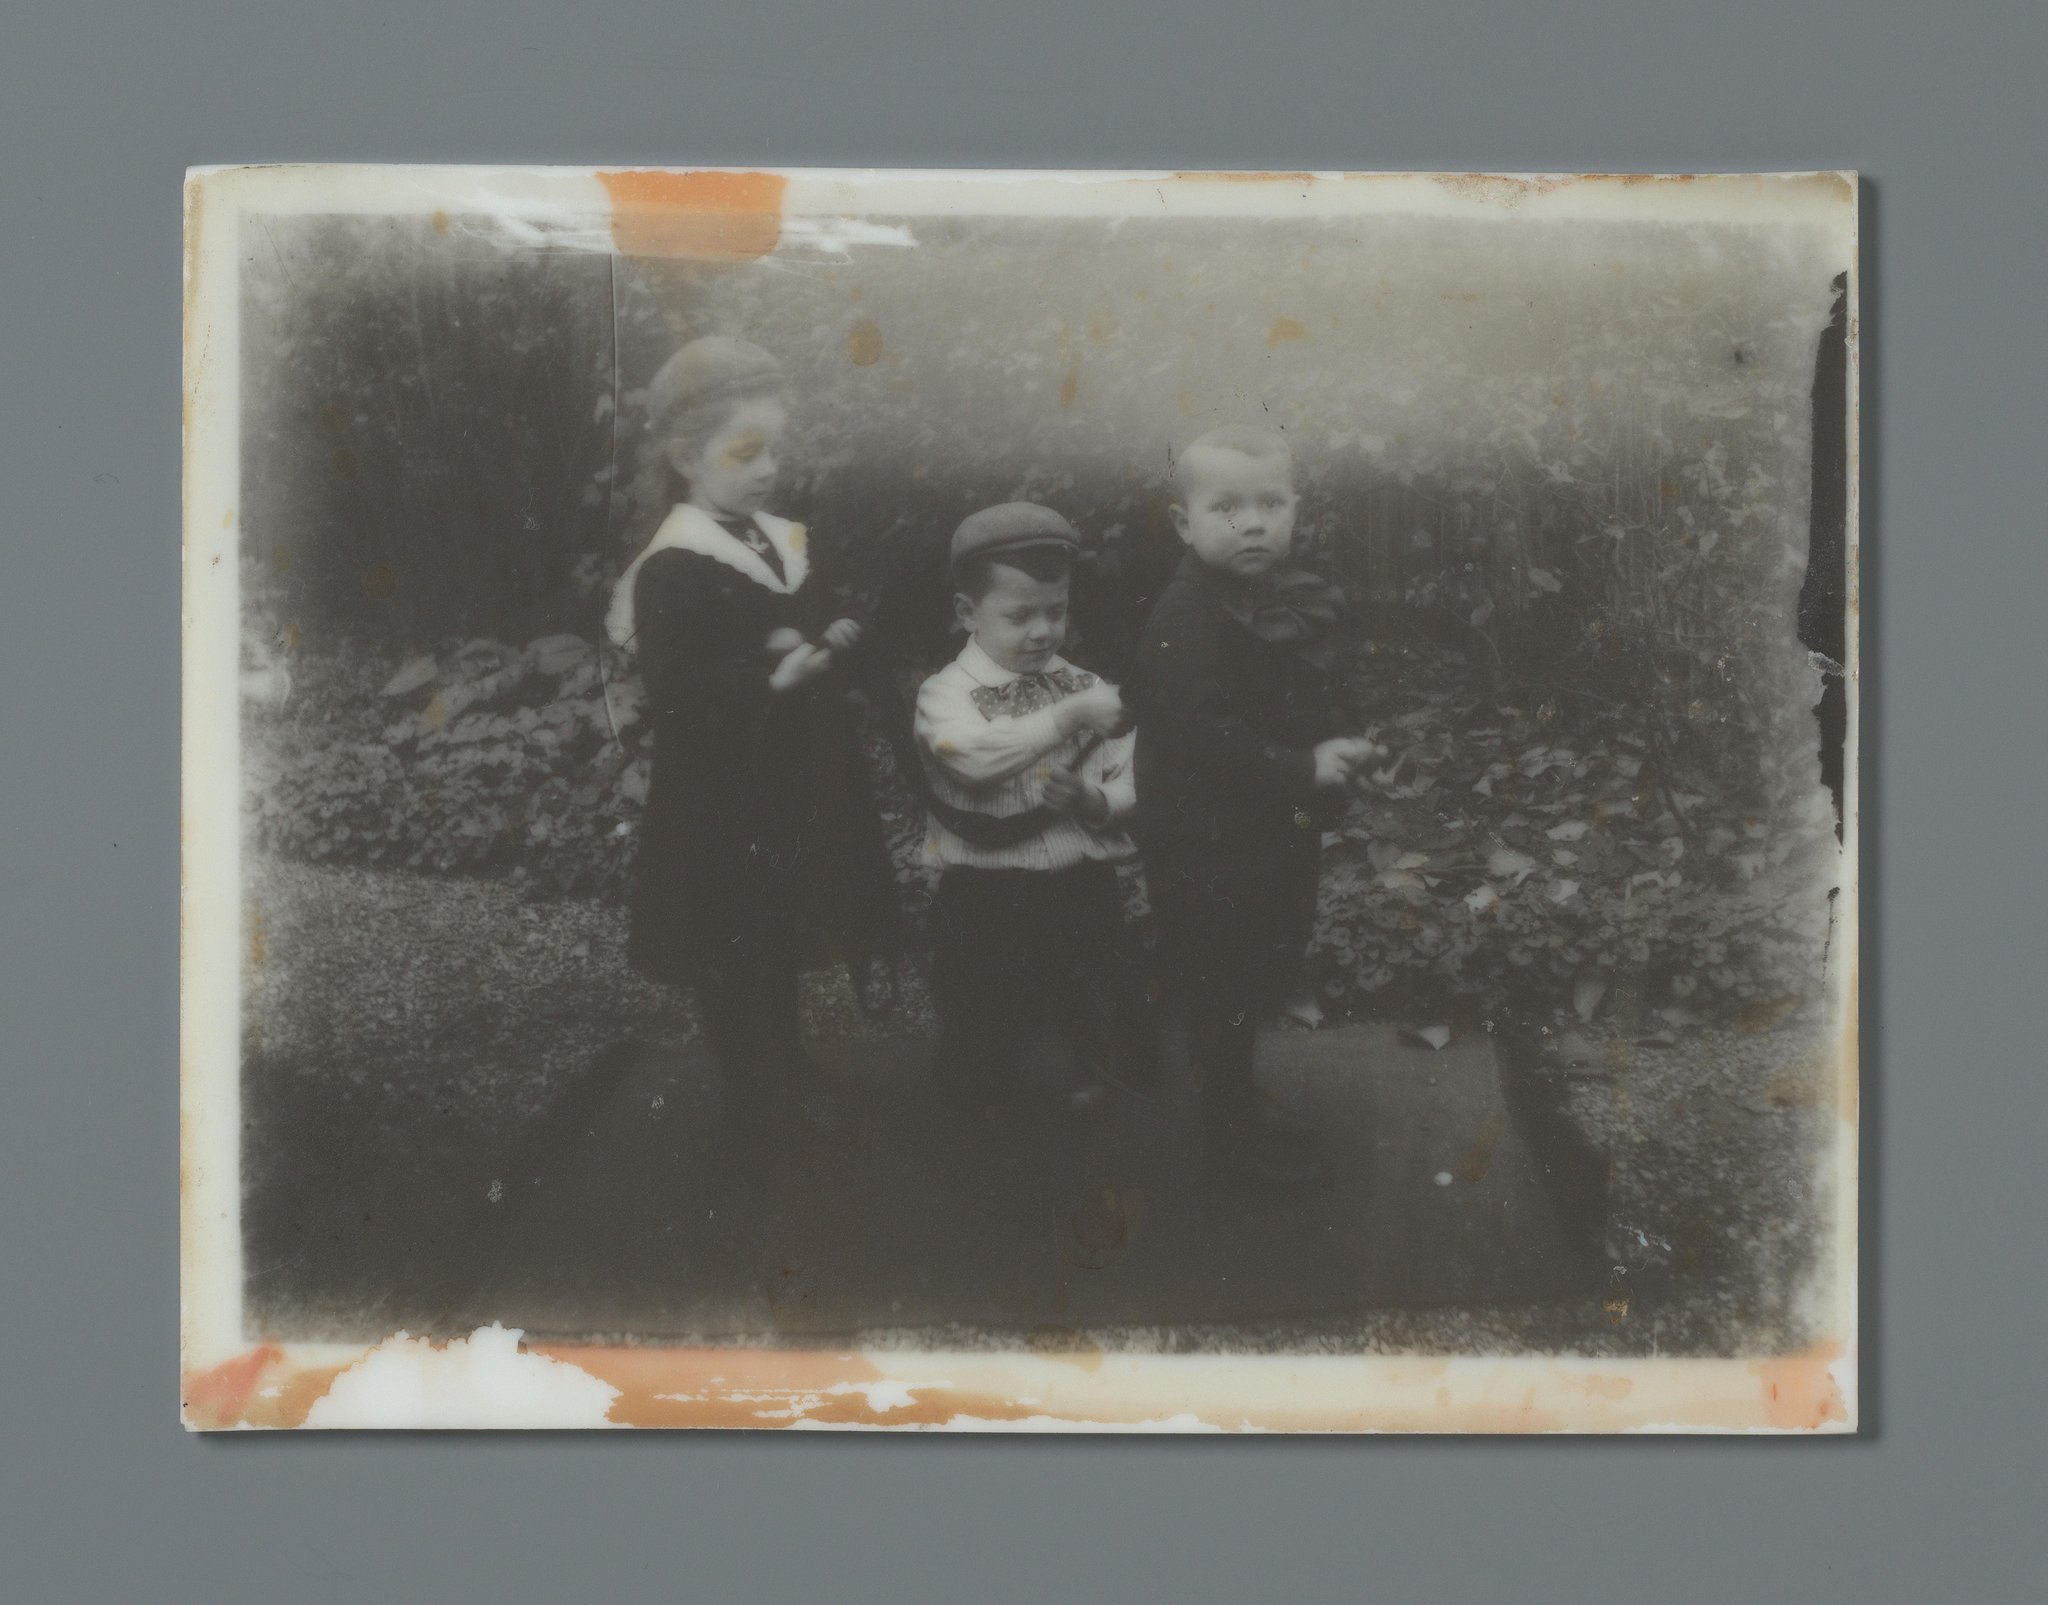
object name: photograph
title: Drie kleuters in een tuin spelend met een lint, waarschijnlijk de tweeling Ad (midden) en Johanna (links) en Han (rechts) van der Kop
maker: willem carel van der kop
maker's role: amateurfotograaf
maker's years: 1869-1924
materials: glass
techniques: gelatin silver print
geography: schoonhoven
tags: sculptor, adrianus johannes van der kop (ad), amsterdam, painter, tot, toddler ~ the ages of man